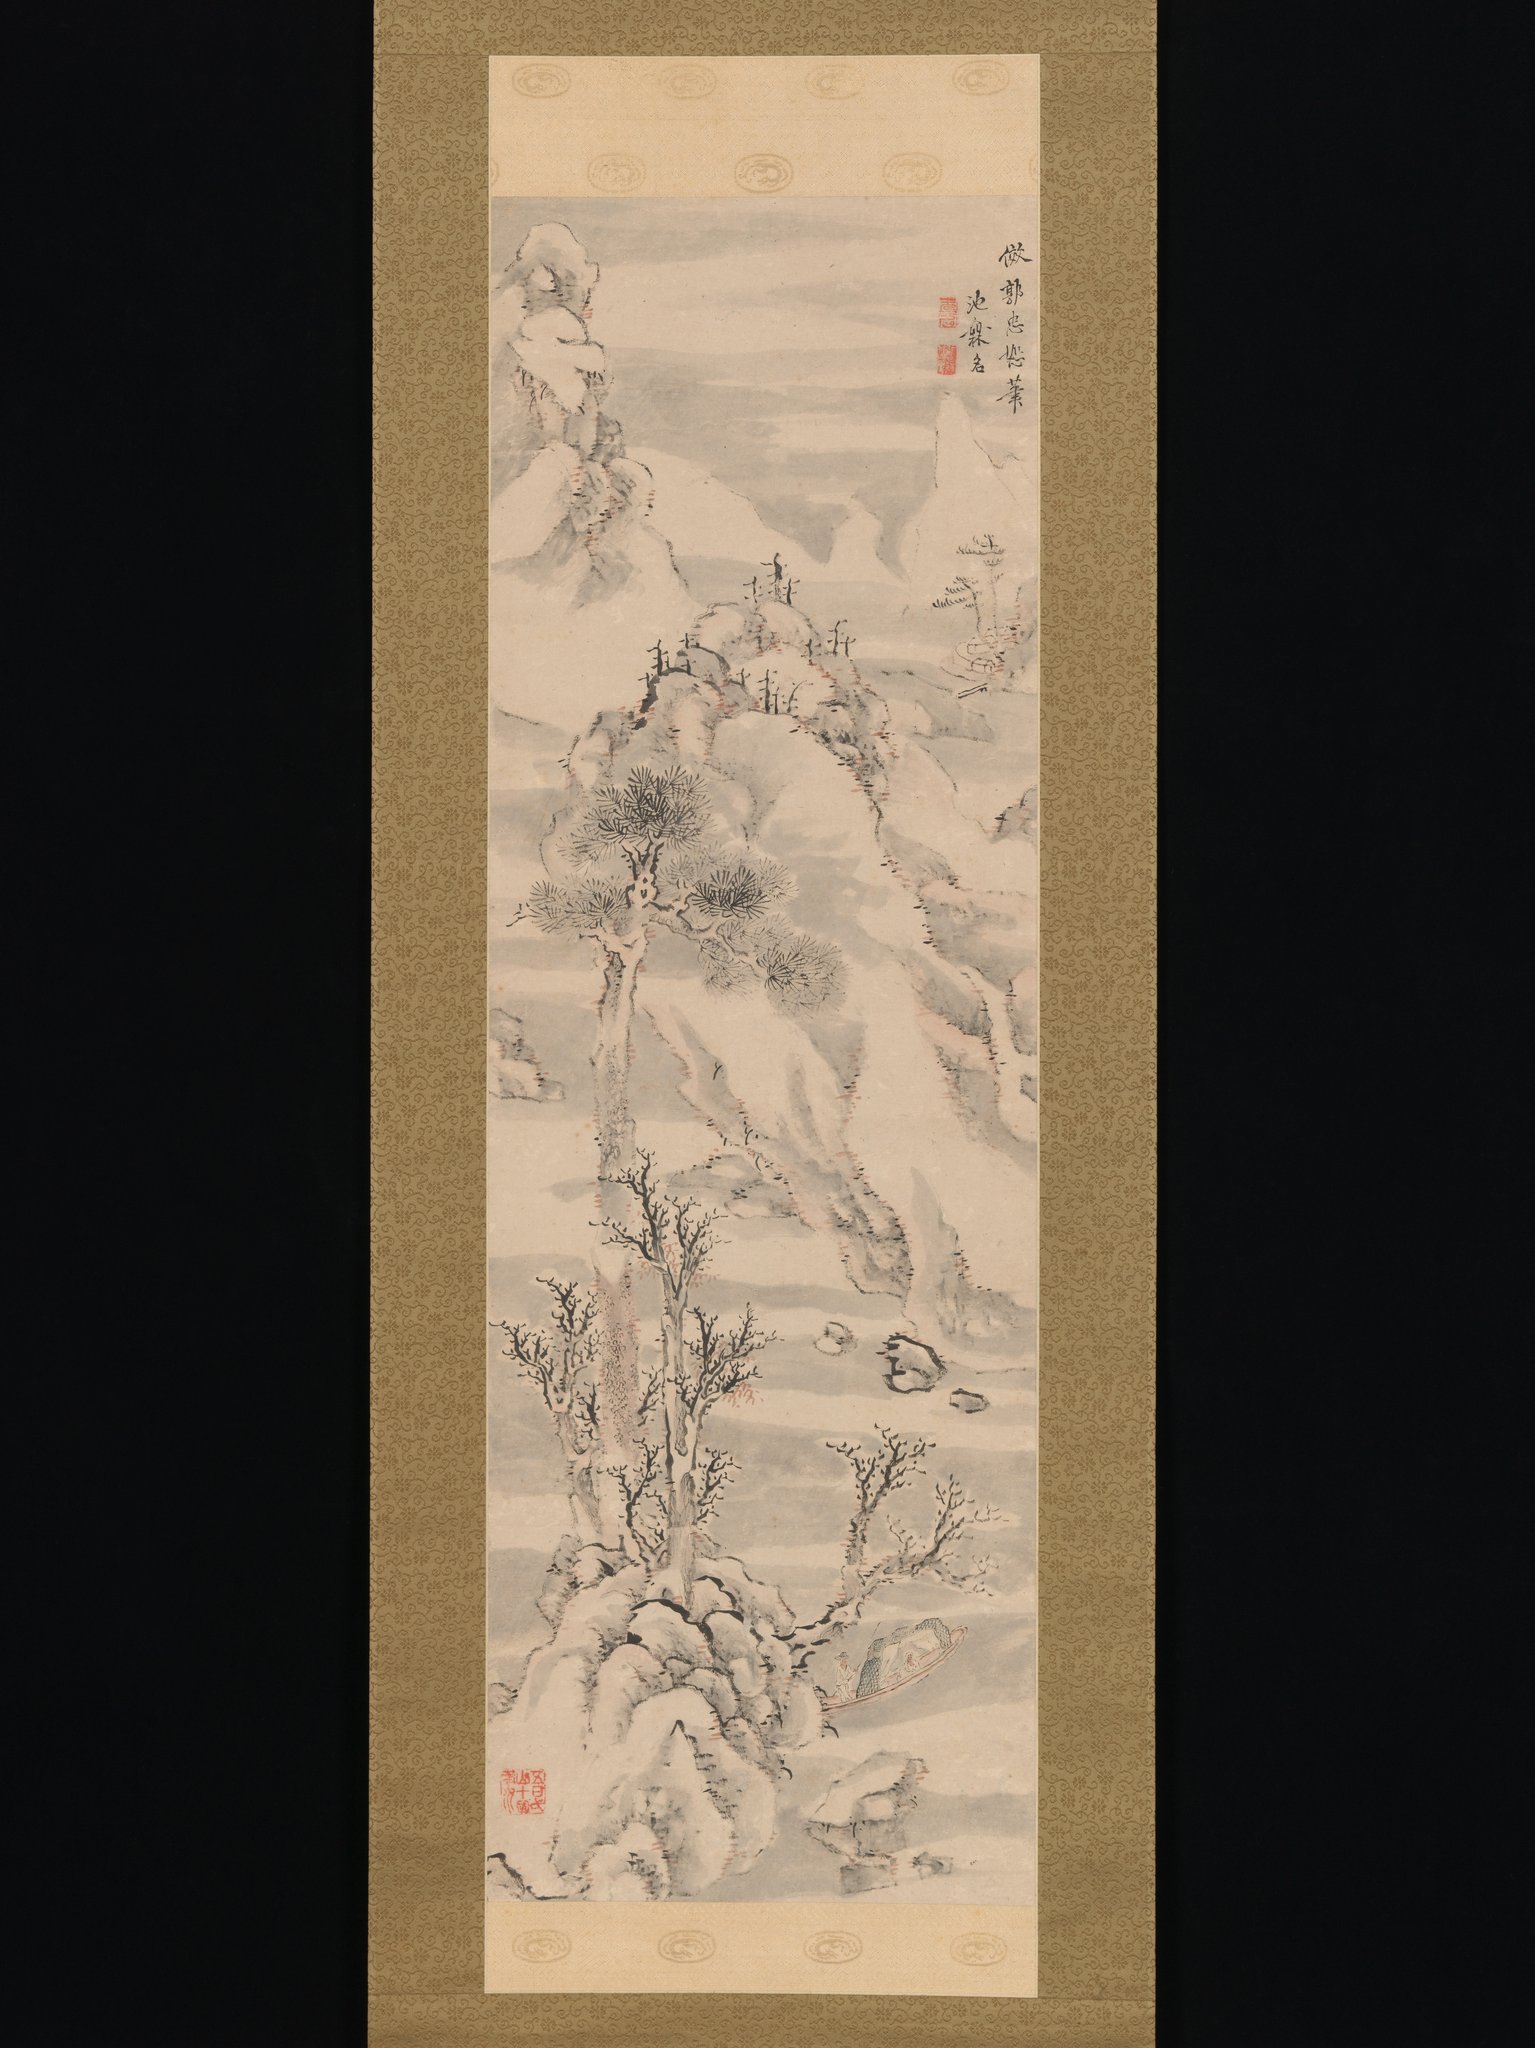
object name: hanging scroll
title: Wintry Landscape, in the Style of Guo Zhongshu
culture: japanese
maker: ike no taiga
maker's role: artist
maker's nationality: japanese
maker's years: 1723-1776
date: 1767-1800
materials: ink, paper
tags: mountains,landscapes